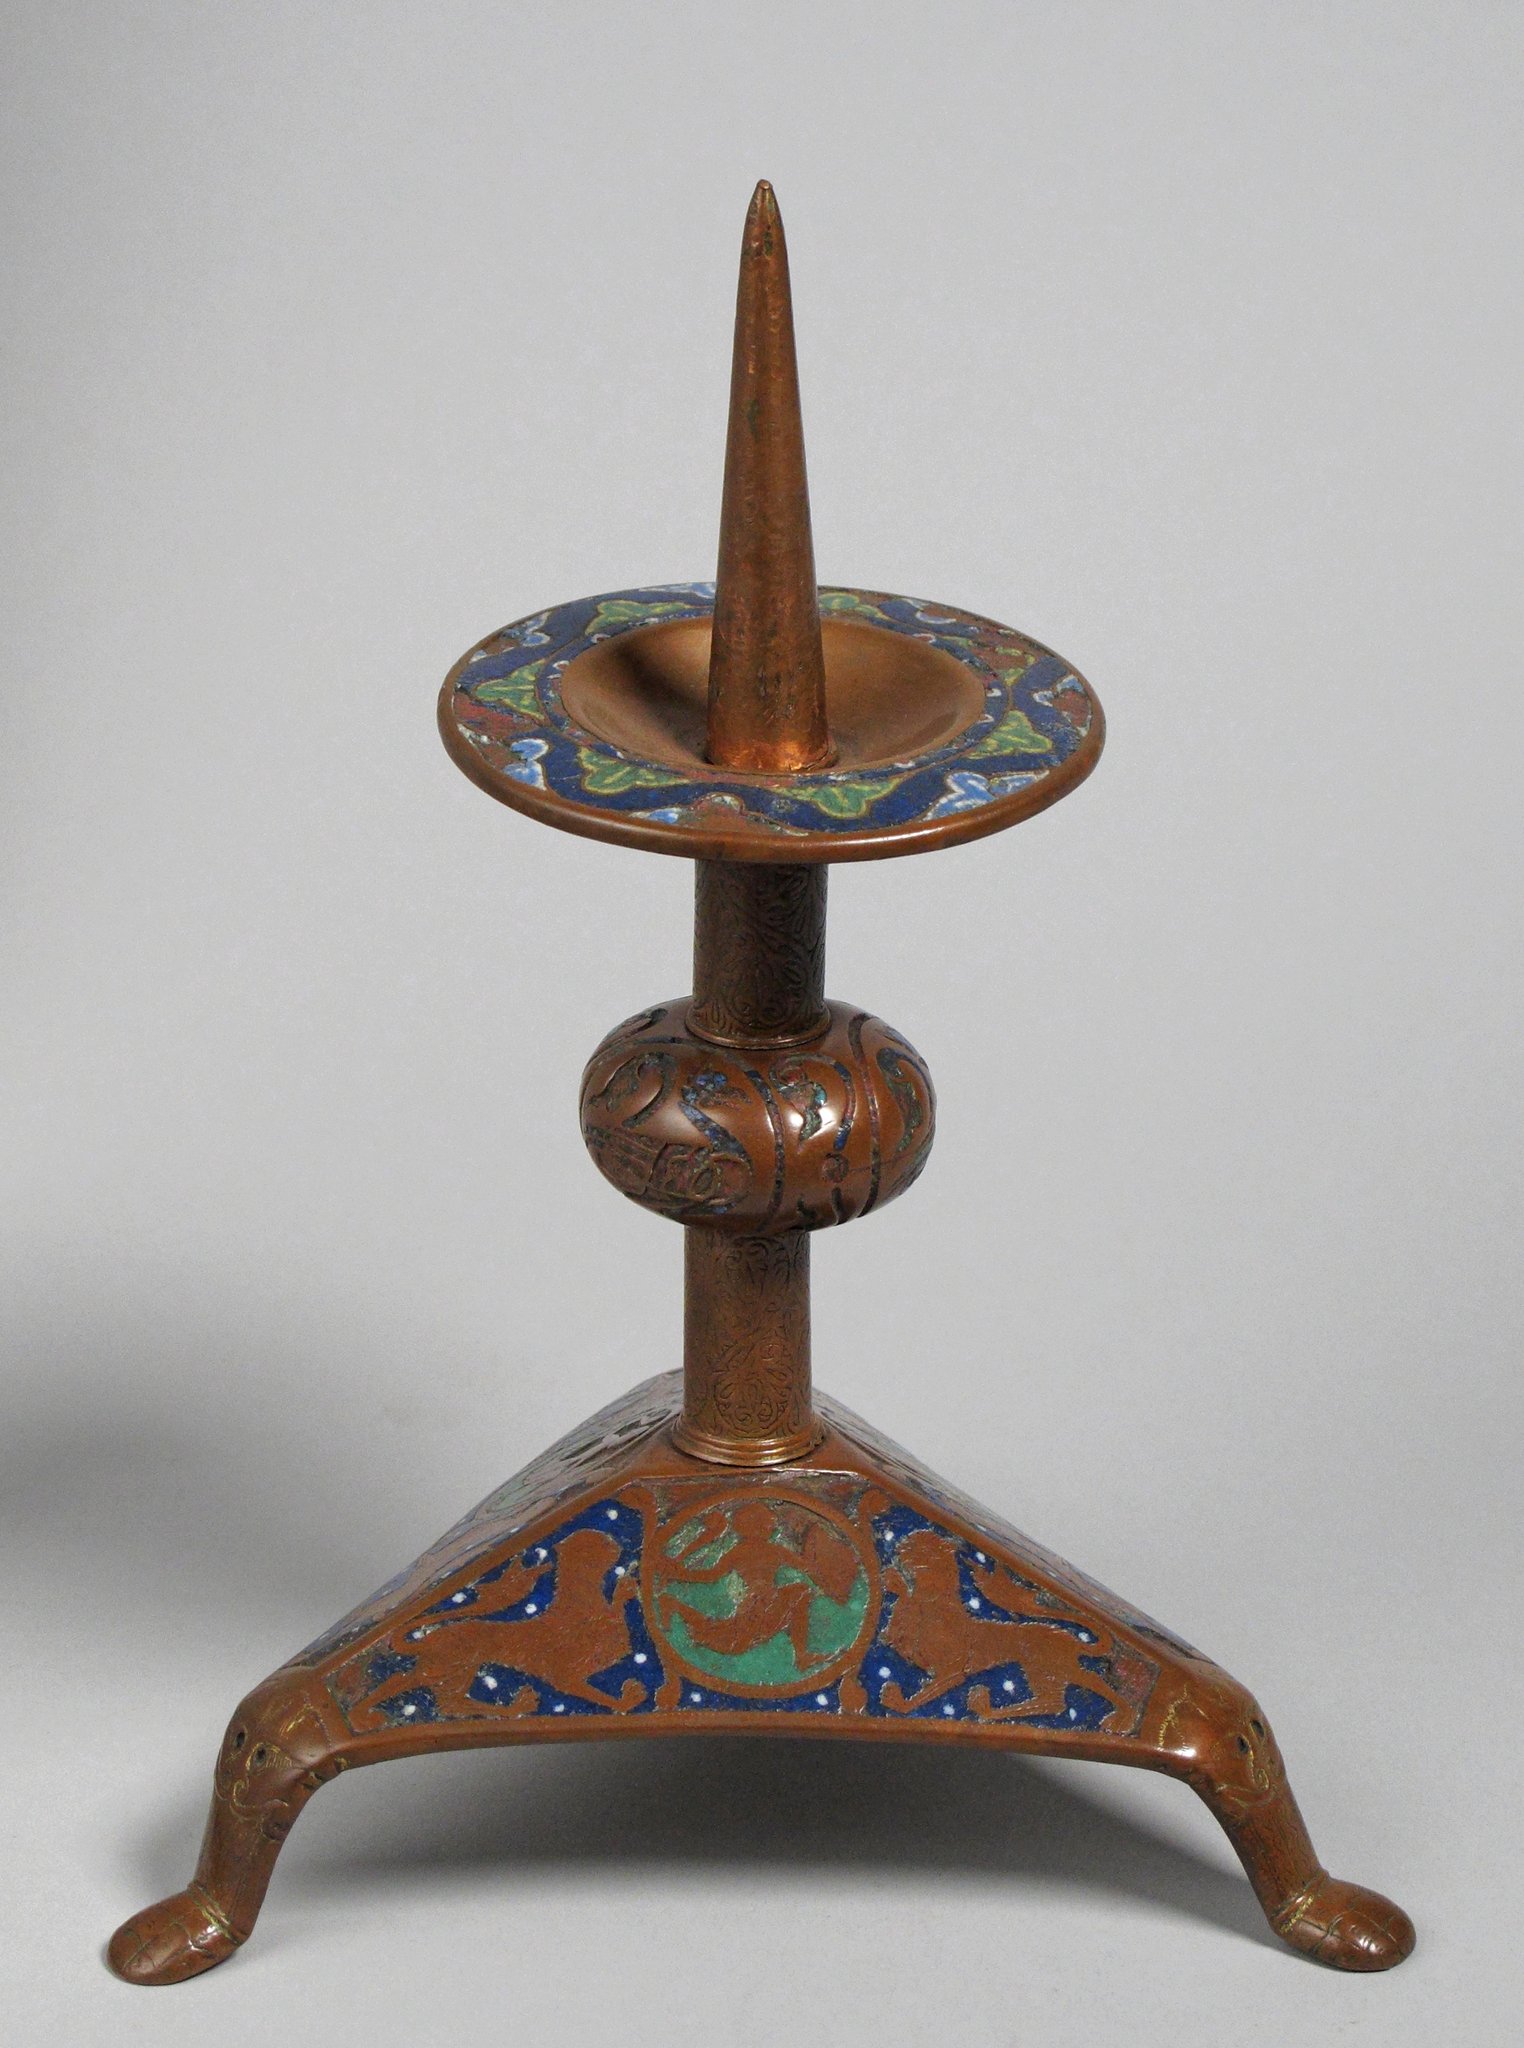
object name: candlestick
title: Pricket Candlestick (one of a pair)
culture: french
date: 1180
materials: bronze, copper, enamel, gilt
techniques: enamel, engraving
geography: france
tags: lions